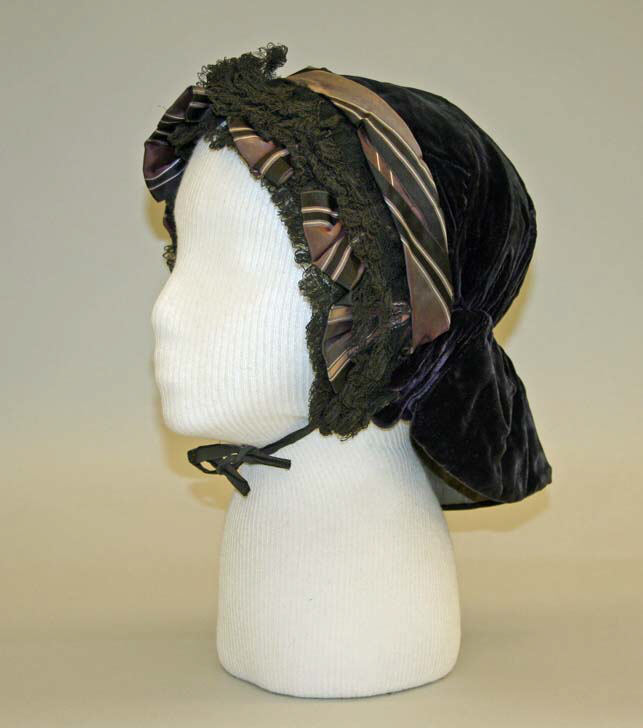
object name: hood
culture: european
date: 1869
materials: silk